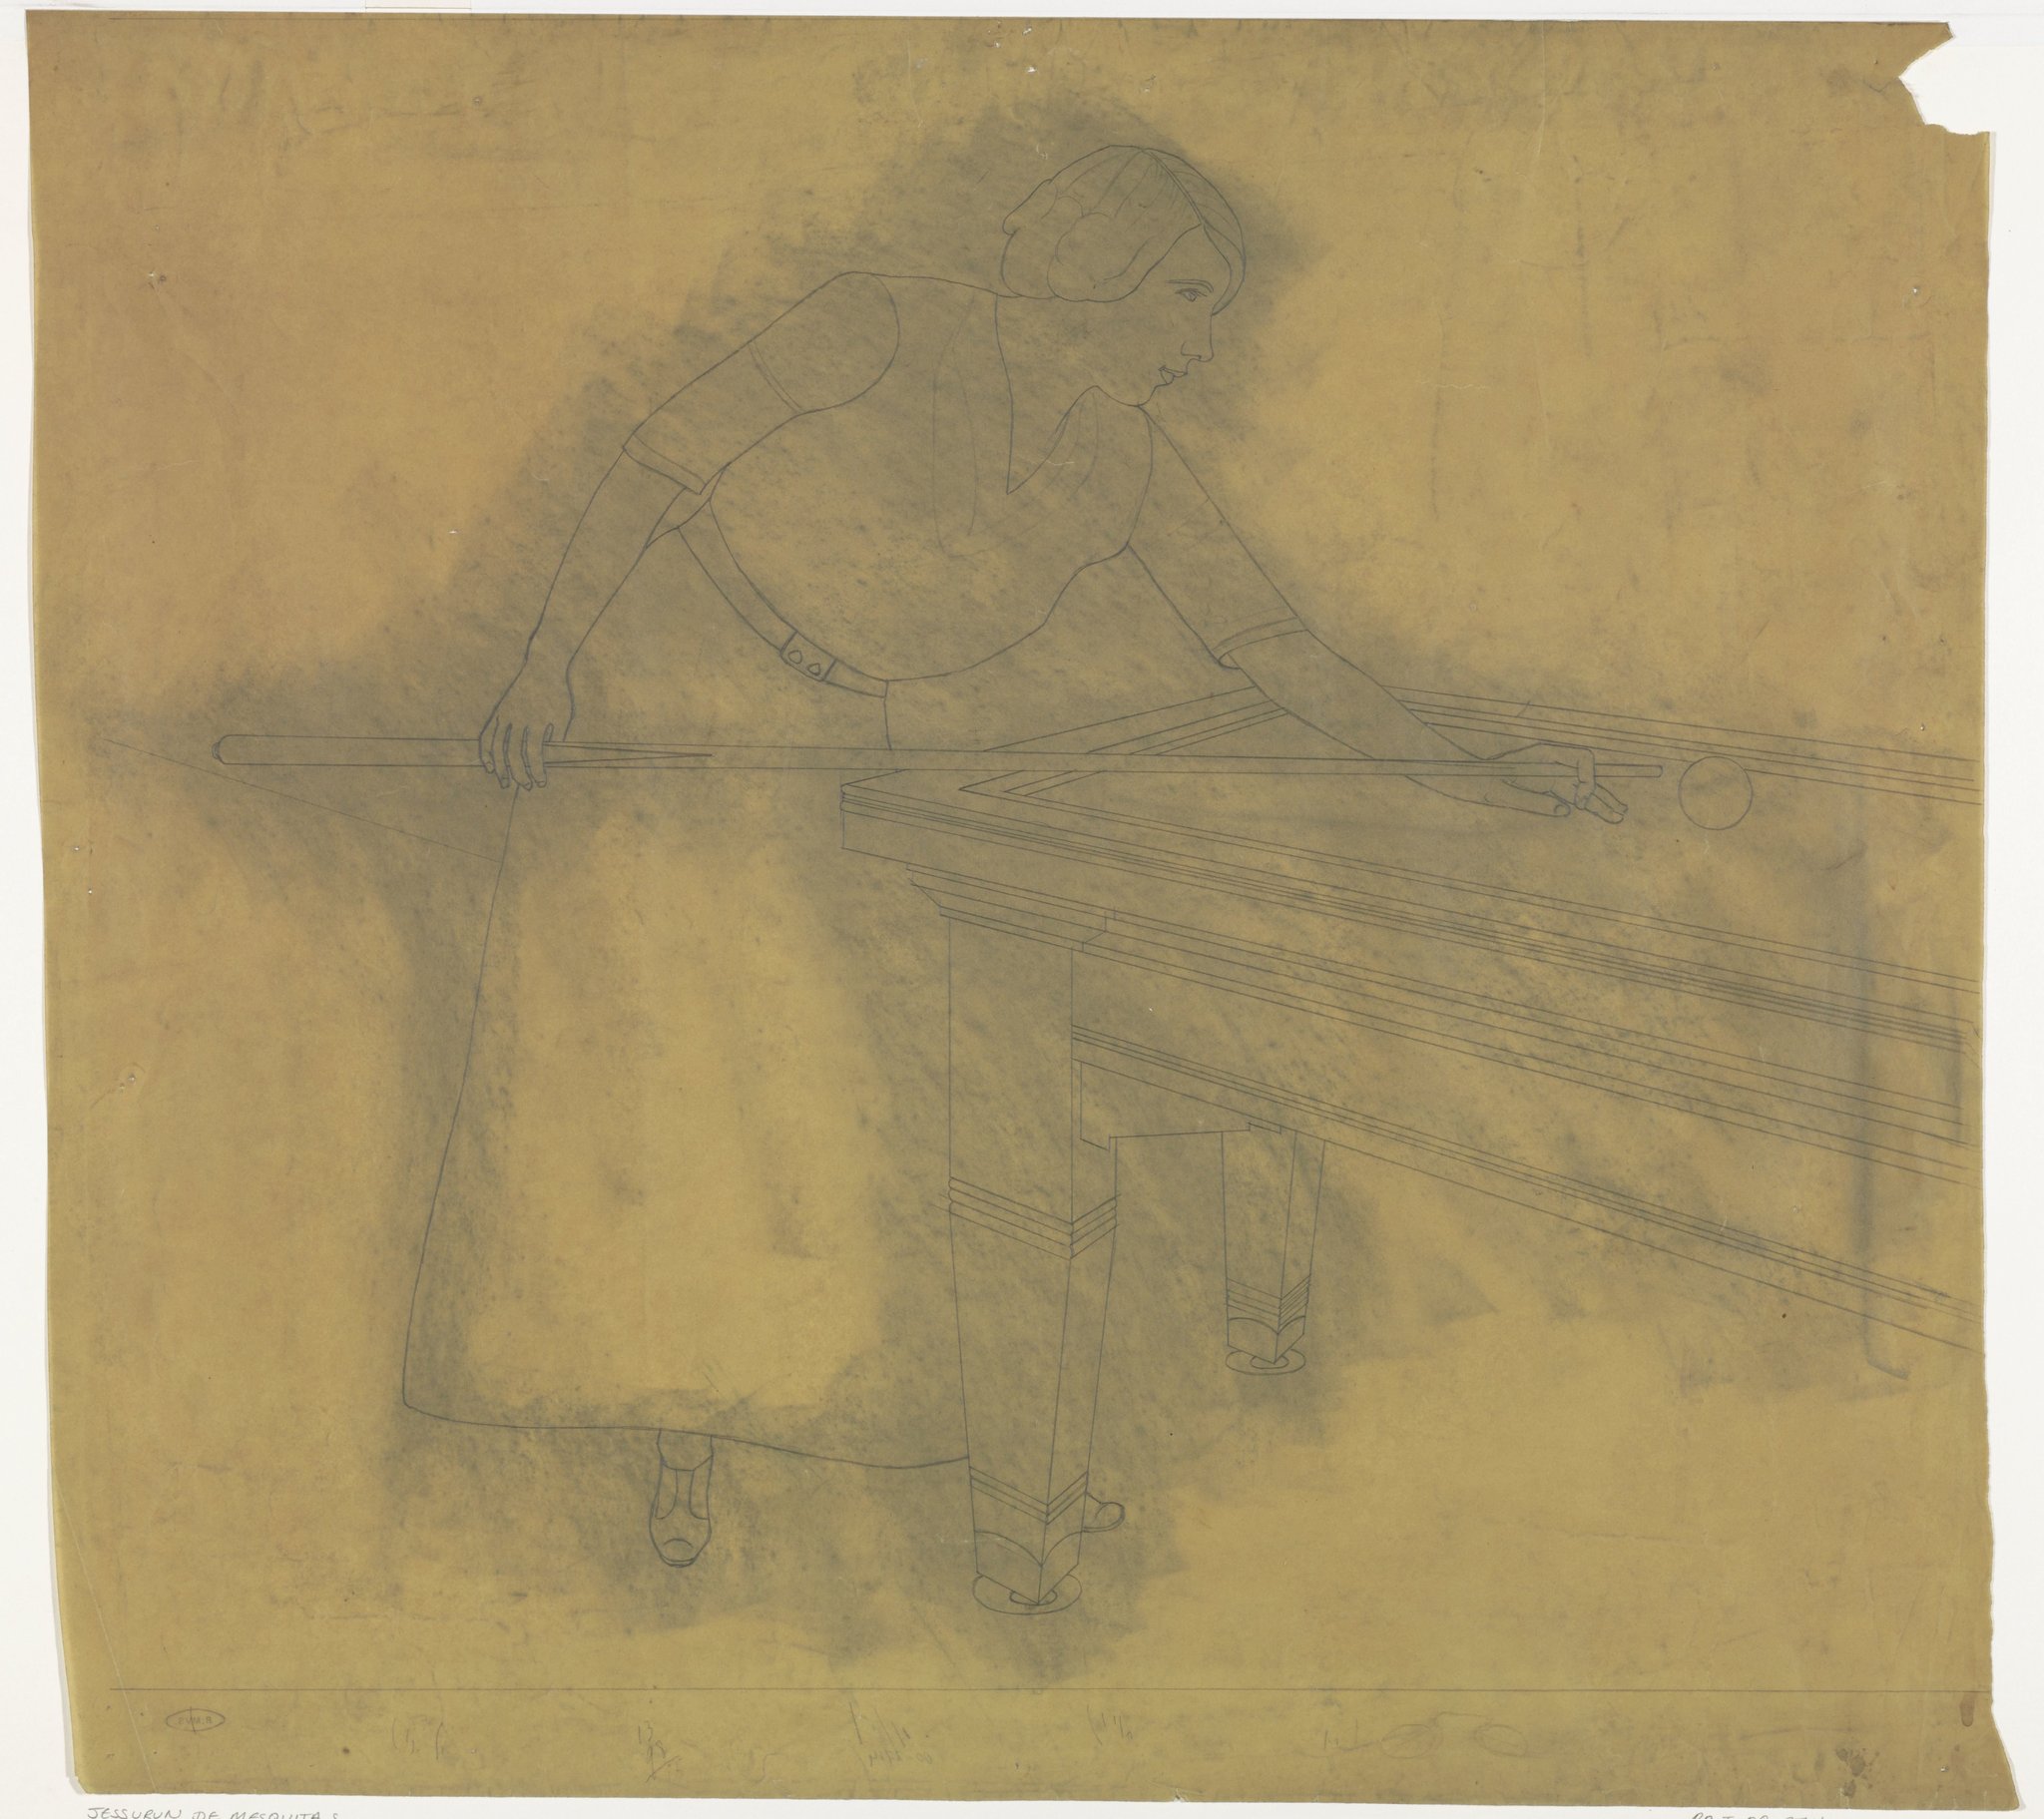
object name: drawing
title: Vrouw die biljart speelt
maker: samuel jessurun de mesquita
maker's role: draughtsman, print maker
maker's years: 1868-1944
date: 1878-1944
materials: chalk, pencil, paper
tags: billiards, female sex; woman